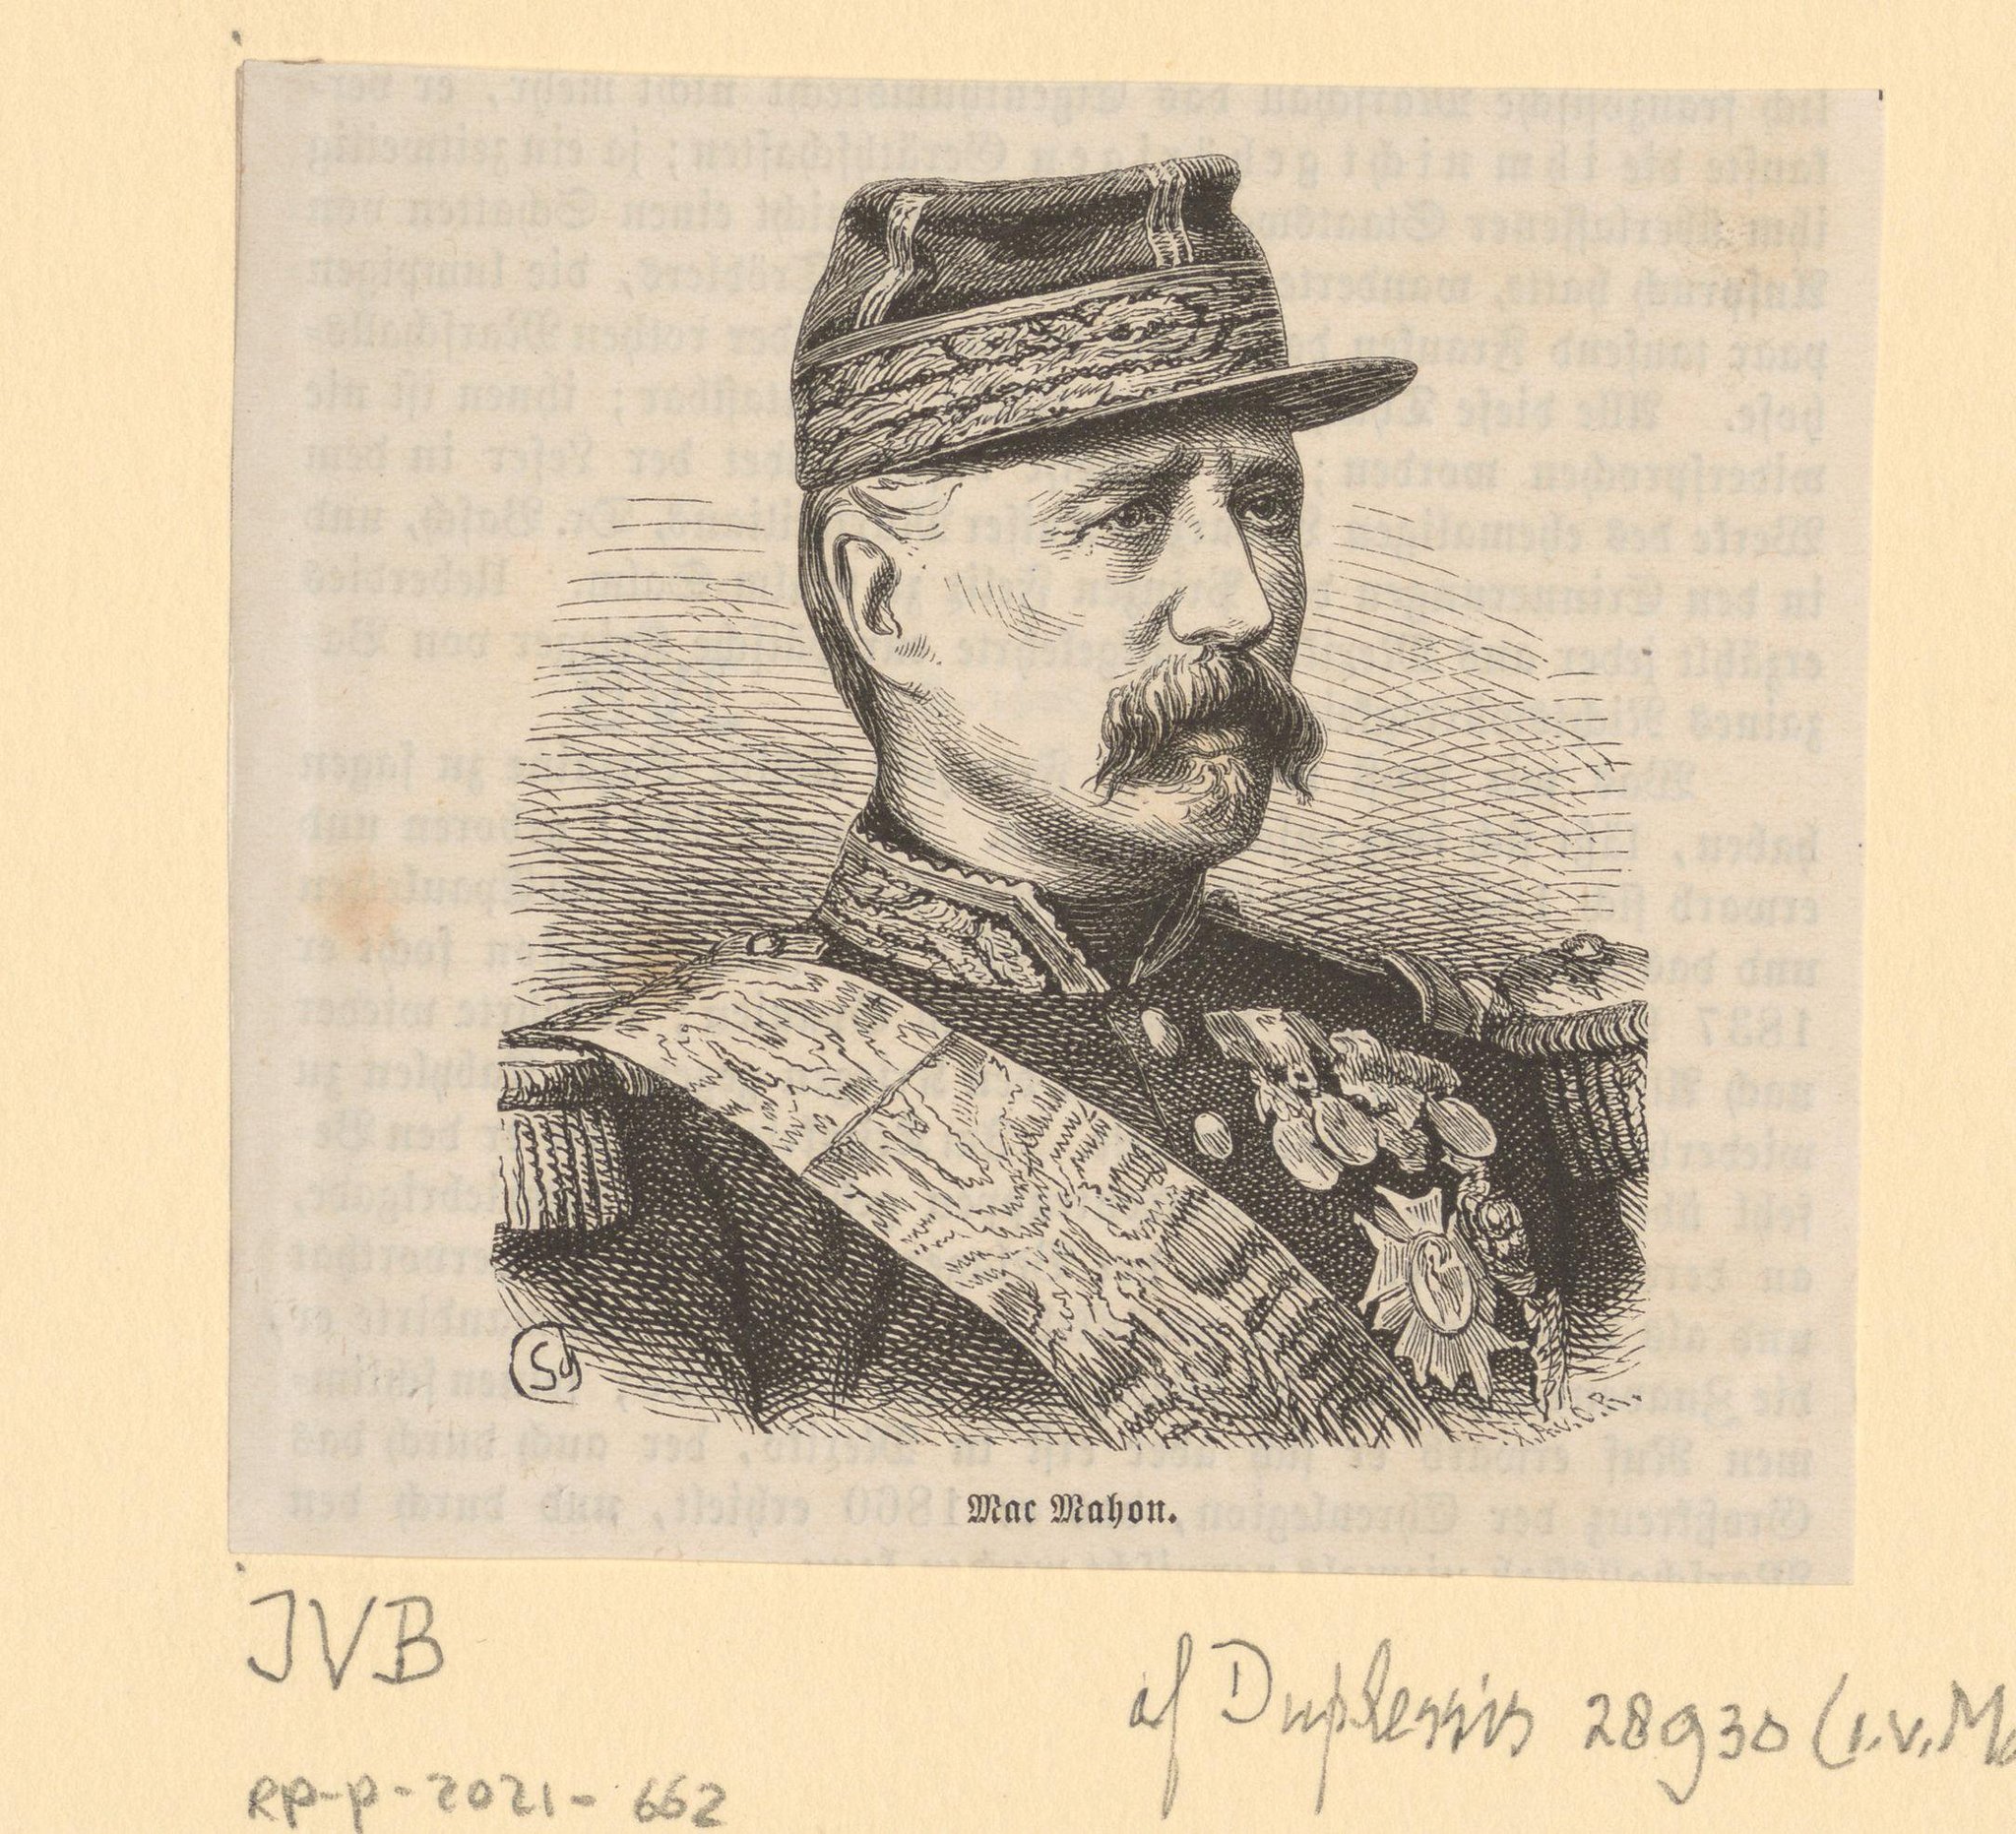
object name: print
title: Portret van Patrice de Mac Mahon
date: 1870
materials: paper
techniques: letterpress printing, engraving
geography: leipzig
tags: politician, historical persons, politician, e.g. party leader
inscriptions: stamp: ‘JVB’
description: Prent uit: Daheim ein deutsches Familienblatt mit Illustrationen (1870), p. 730.